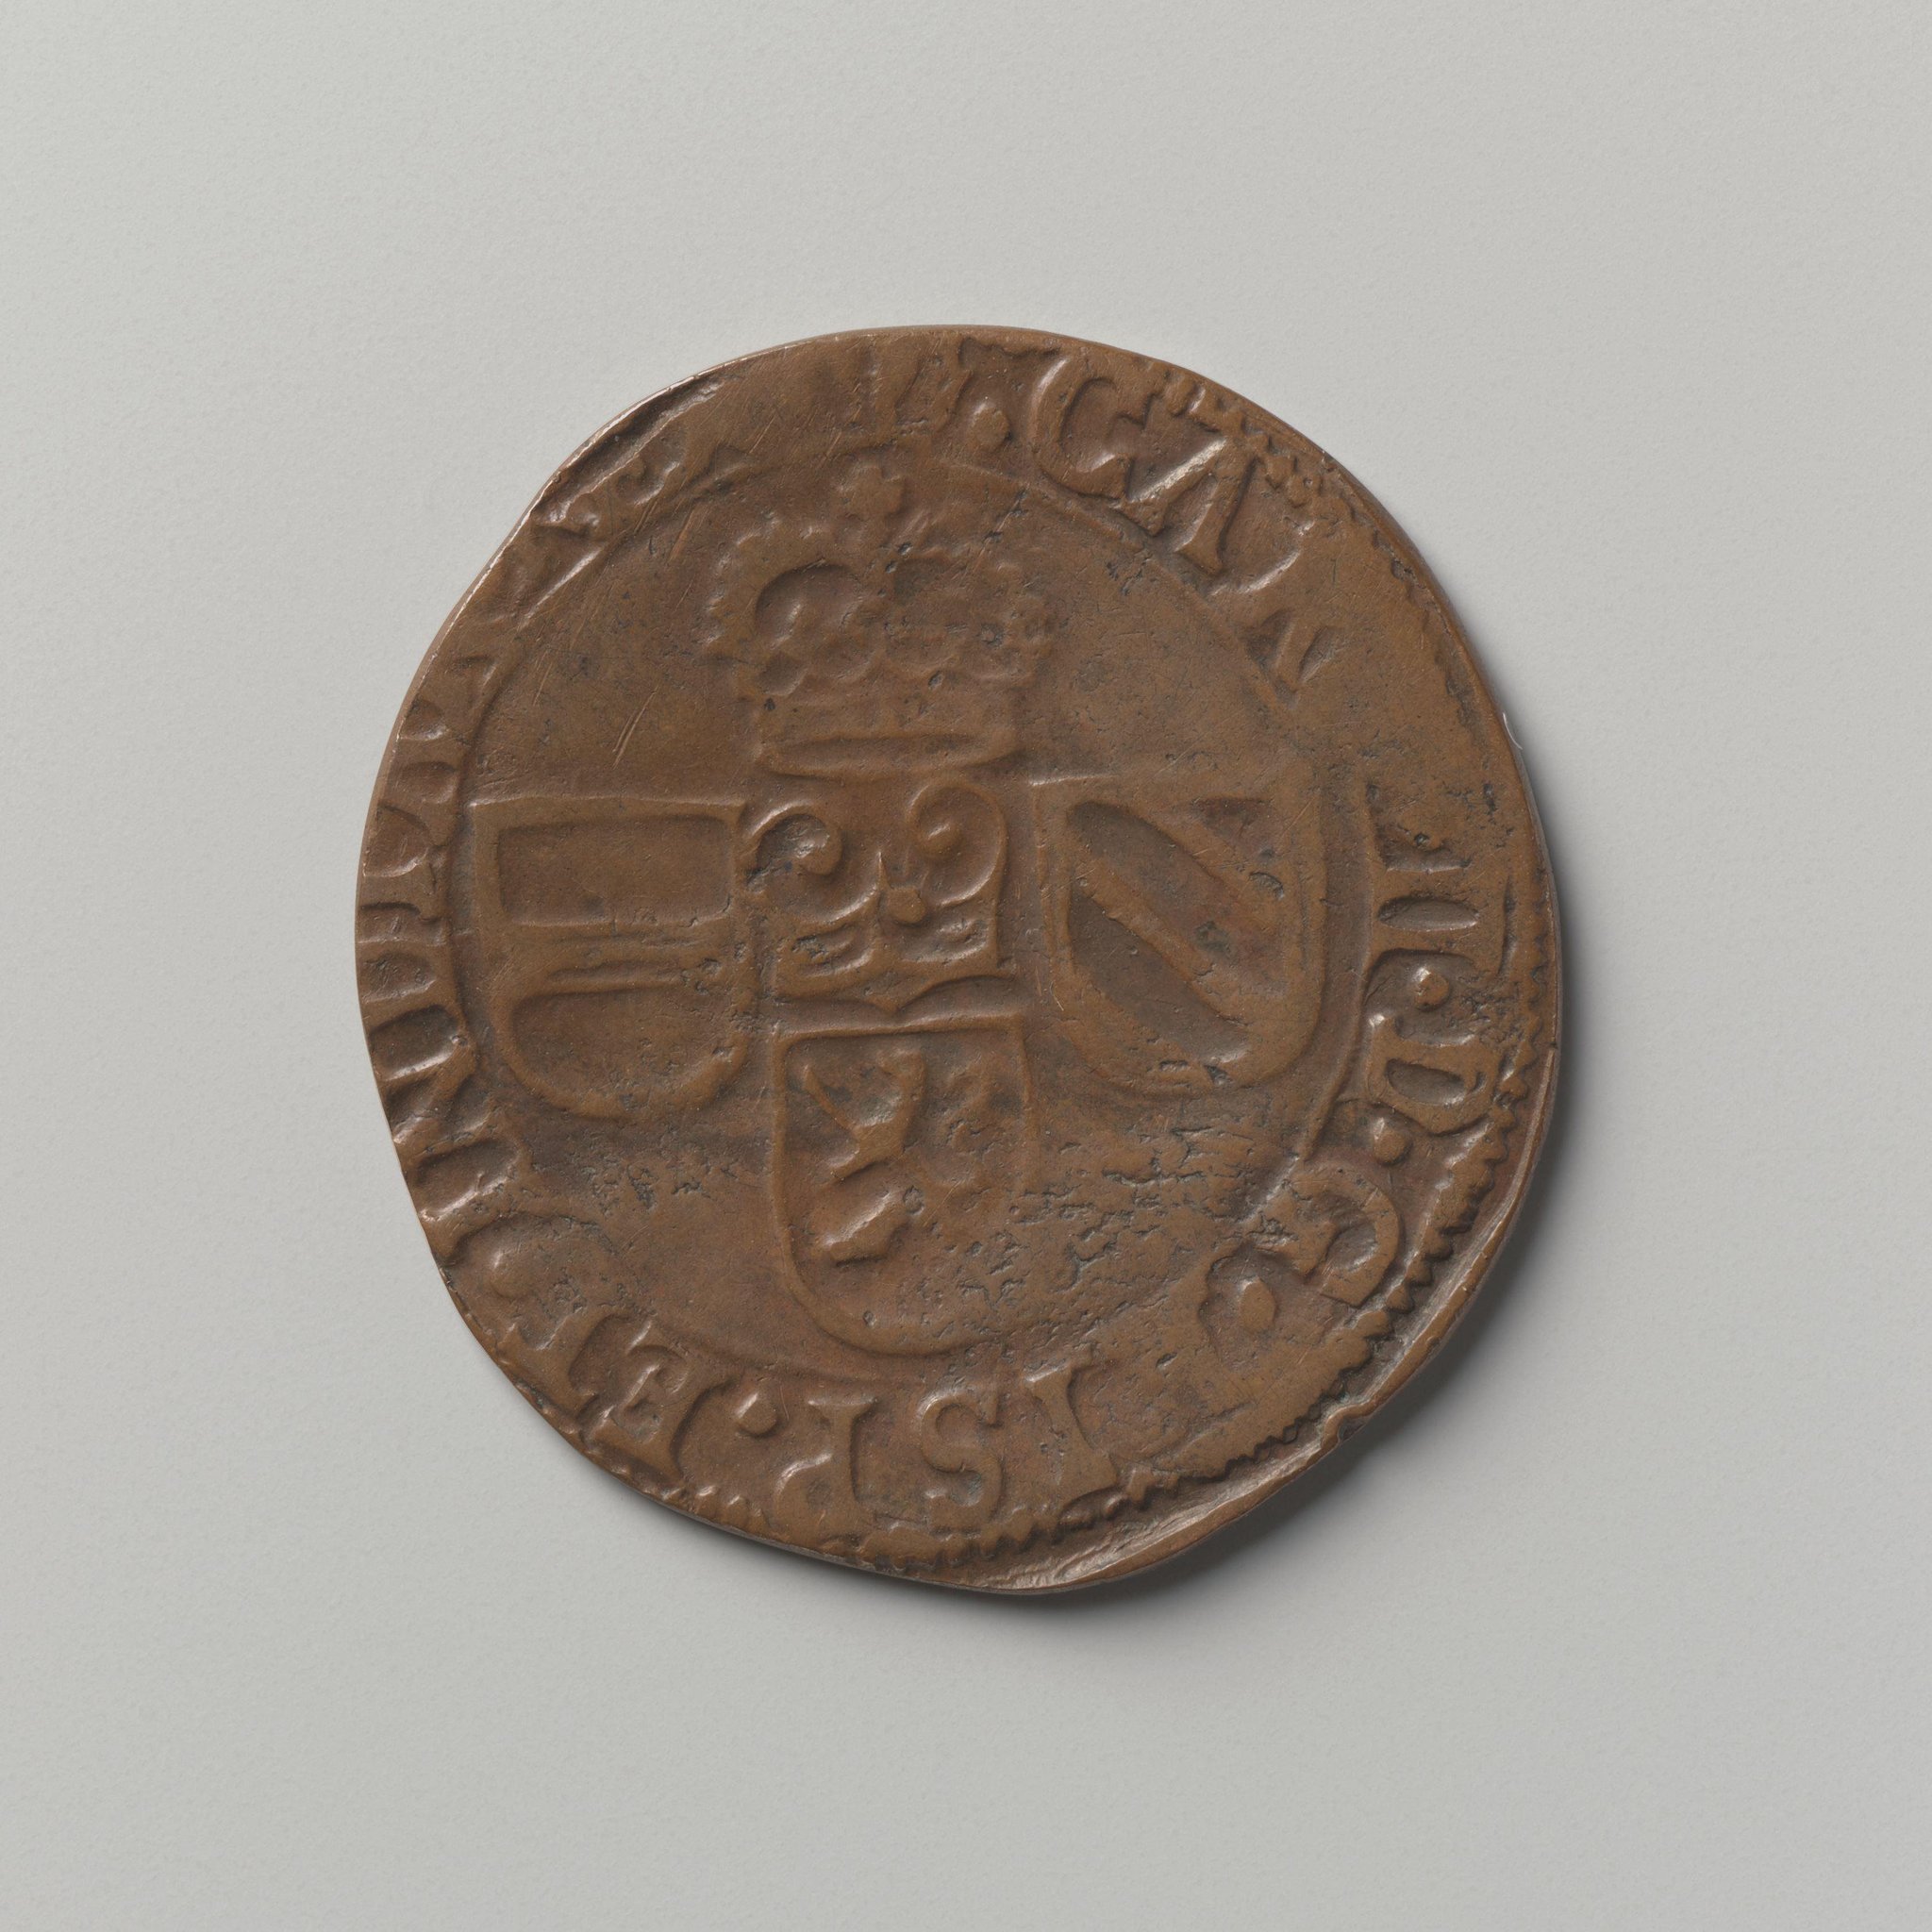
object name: coin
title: Brabant, Karel II, oord, 1685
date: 1685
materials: copper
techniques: striking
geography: antwerp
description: Koperen munt. Voorzijde: tussen jaartal gekroond samengesteld wapenschild. In omschrift BARG [i.p.v. BVRG]. Keerzijde: onder kroon vuurijzer. links en rechts daarvan en daaronder wapenschild. Boven kroon hand [?].